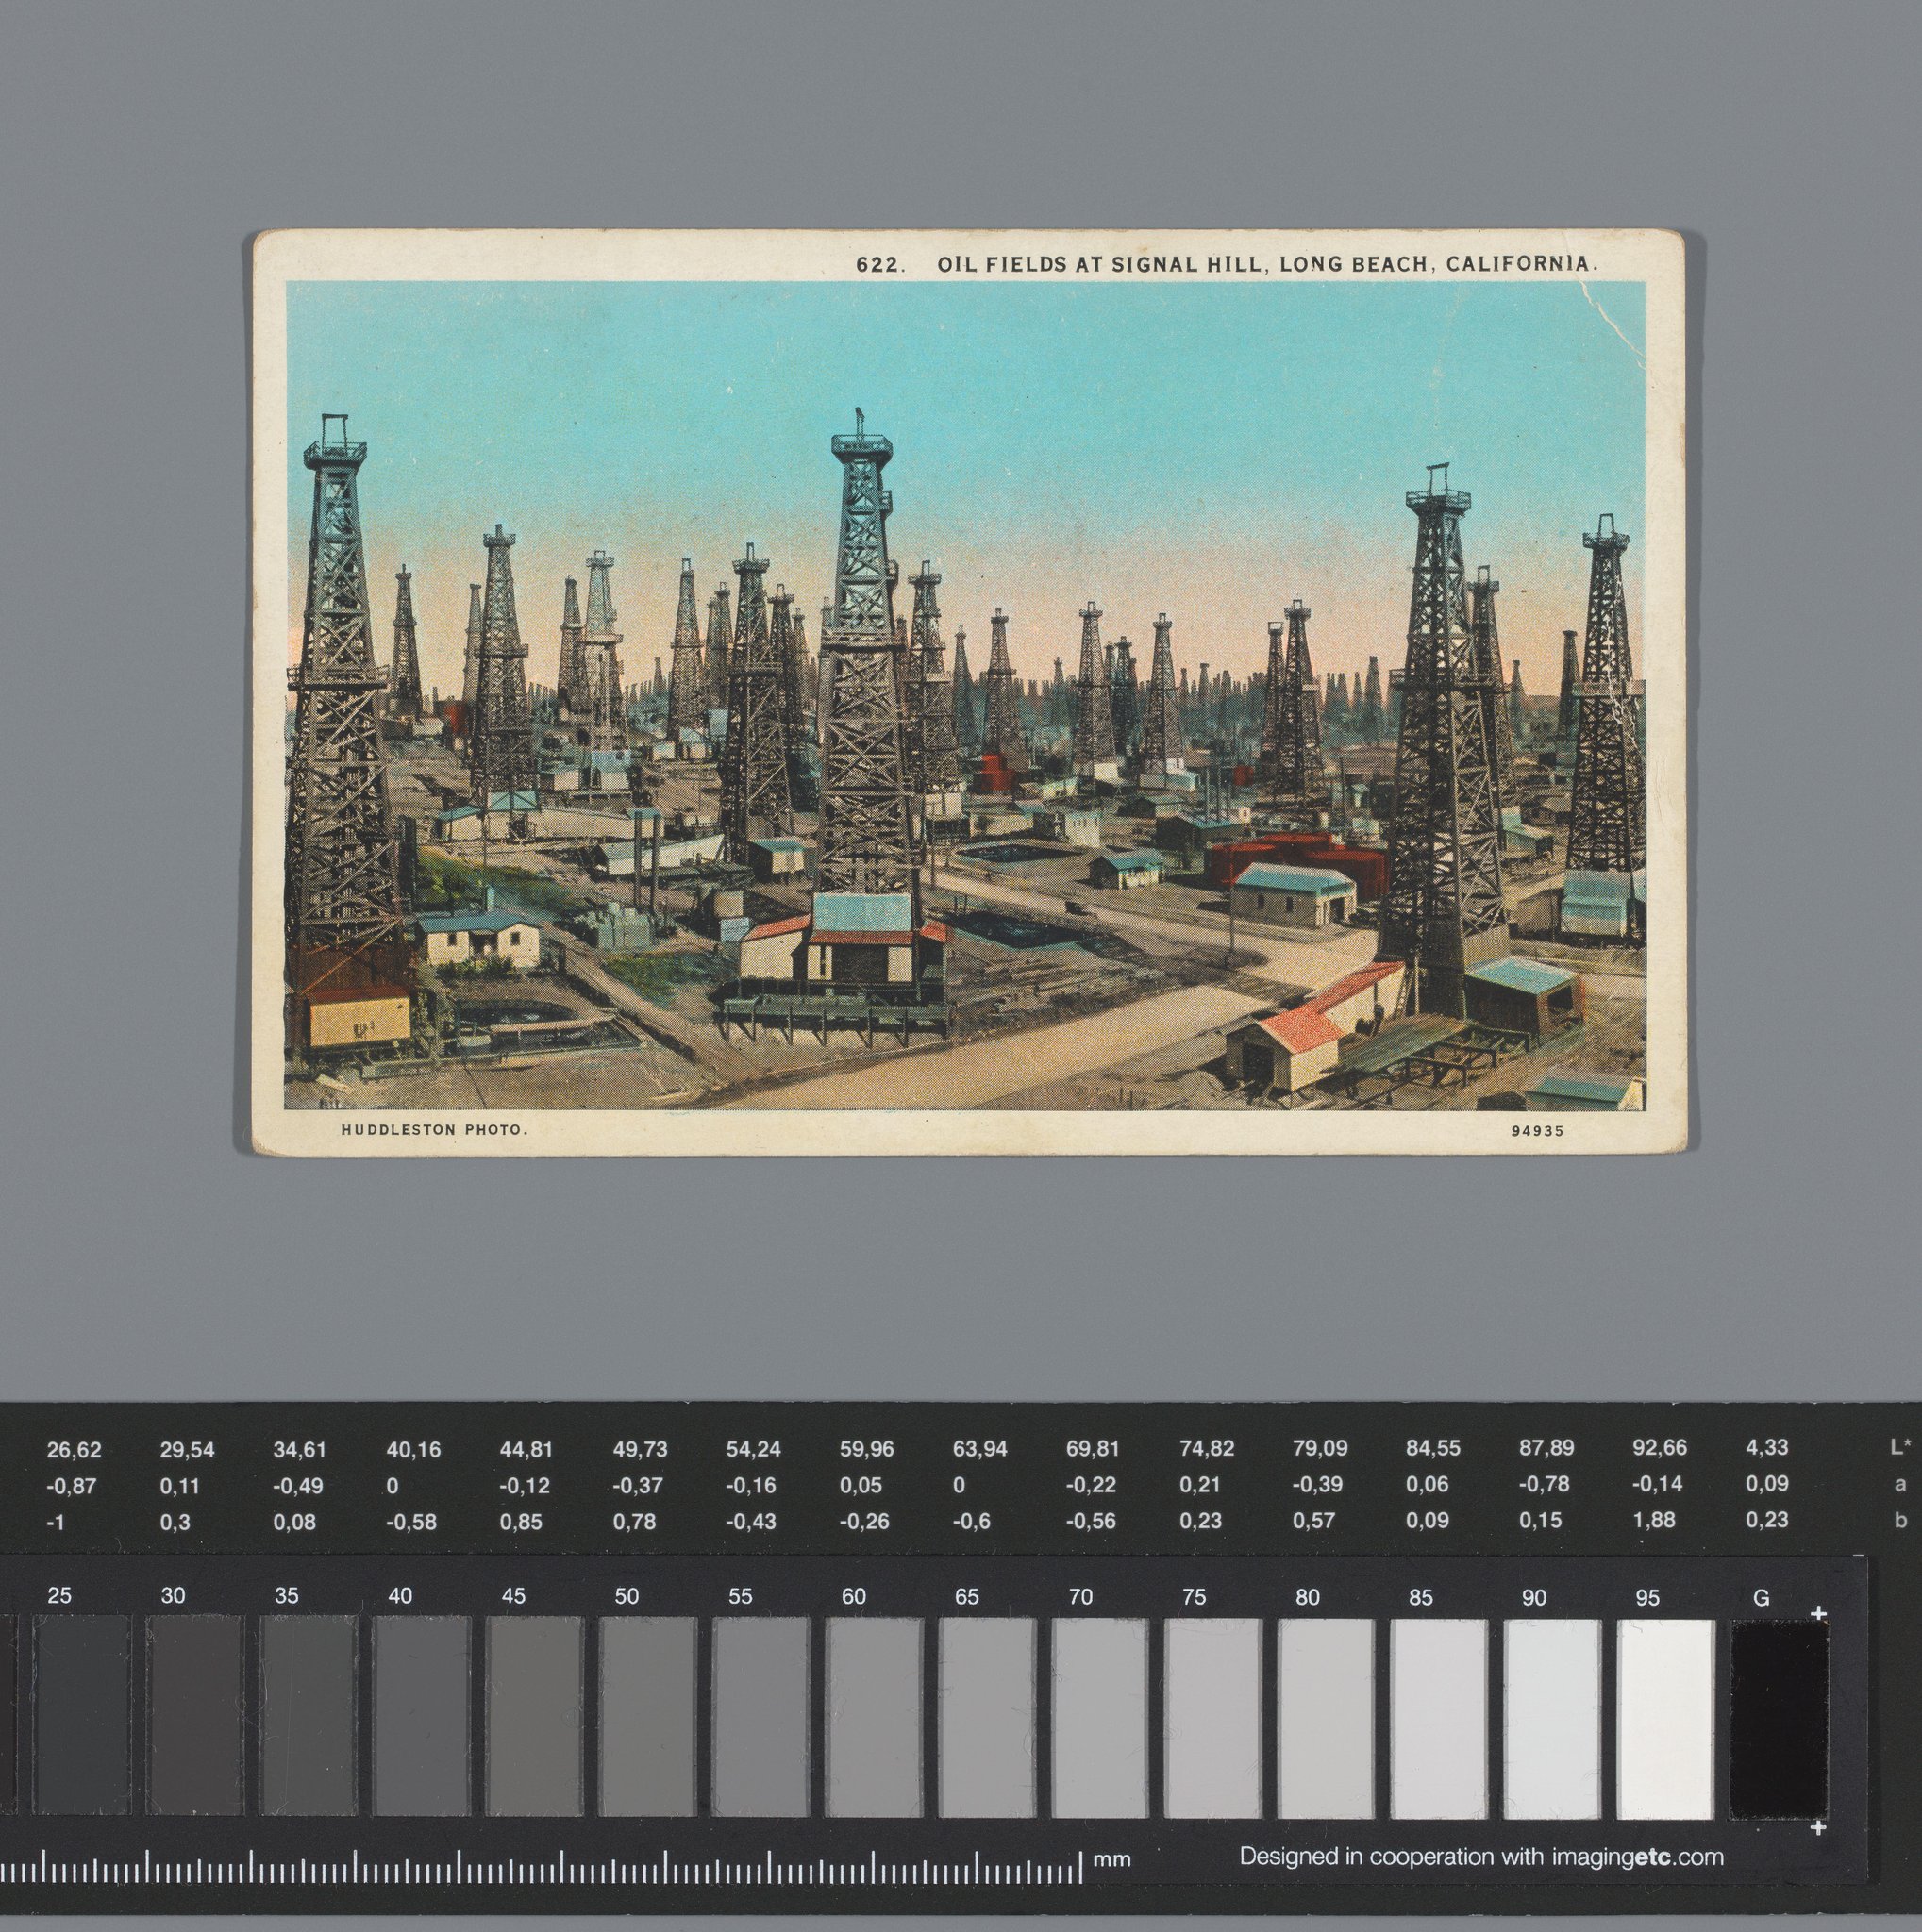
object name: ansichtkaart, prentbriefkaart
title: Signal Hill, Long Beach, Californië met boortorens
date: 1932-1950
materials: paper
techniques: lithograph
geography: united states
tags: californië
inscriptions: inscription: ‘622. OIL FIELDS AT SIGNAL HILL, LONG BEACH, CALIFORNIA. // HUDDLESTON PHOTO. / 94935’, inscription: ‘WESTERN PUBLISHING & NOVELTY CO., LOS ANGELES, CALIF’